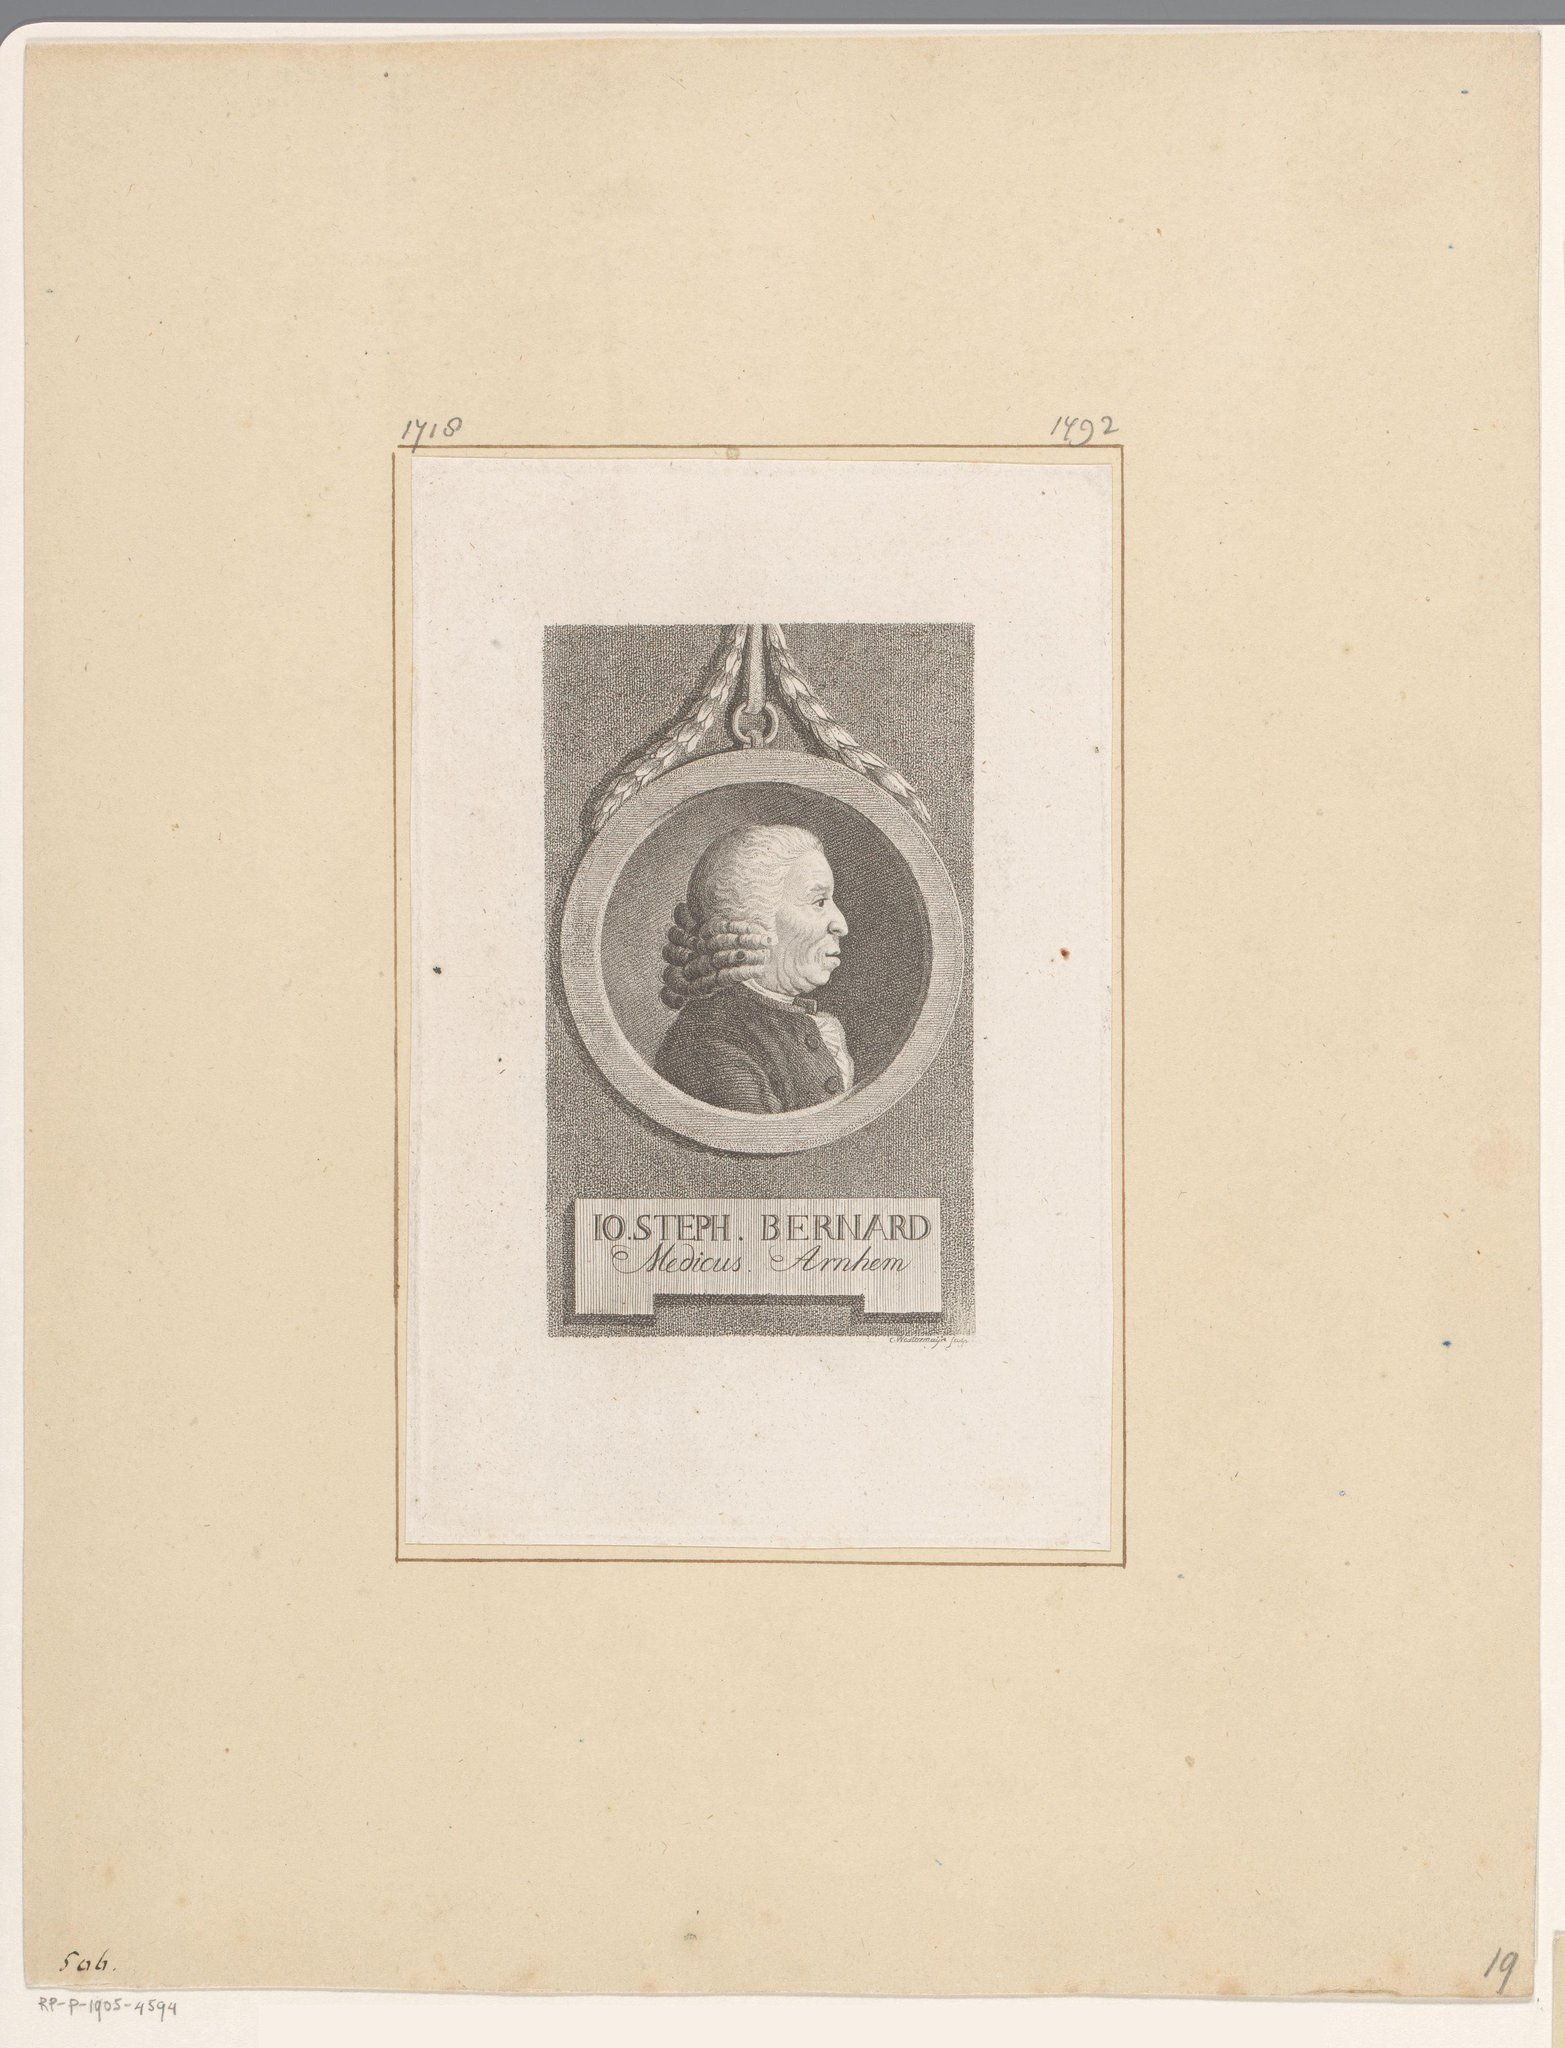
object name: print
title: Portret van Johann Stephan Bernard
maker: konrad westermayr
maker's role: print maker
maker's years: 1765-1834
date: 1775-1834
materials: paper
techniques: engraving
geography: germany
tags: historical persons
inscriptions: number: ‘506’, collector's mark: Lugt 2228